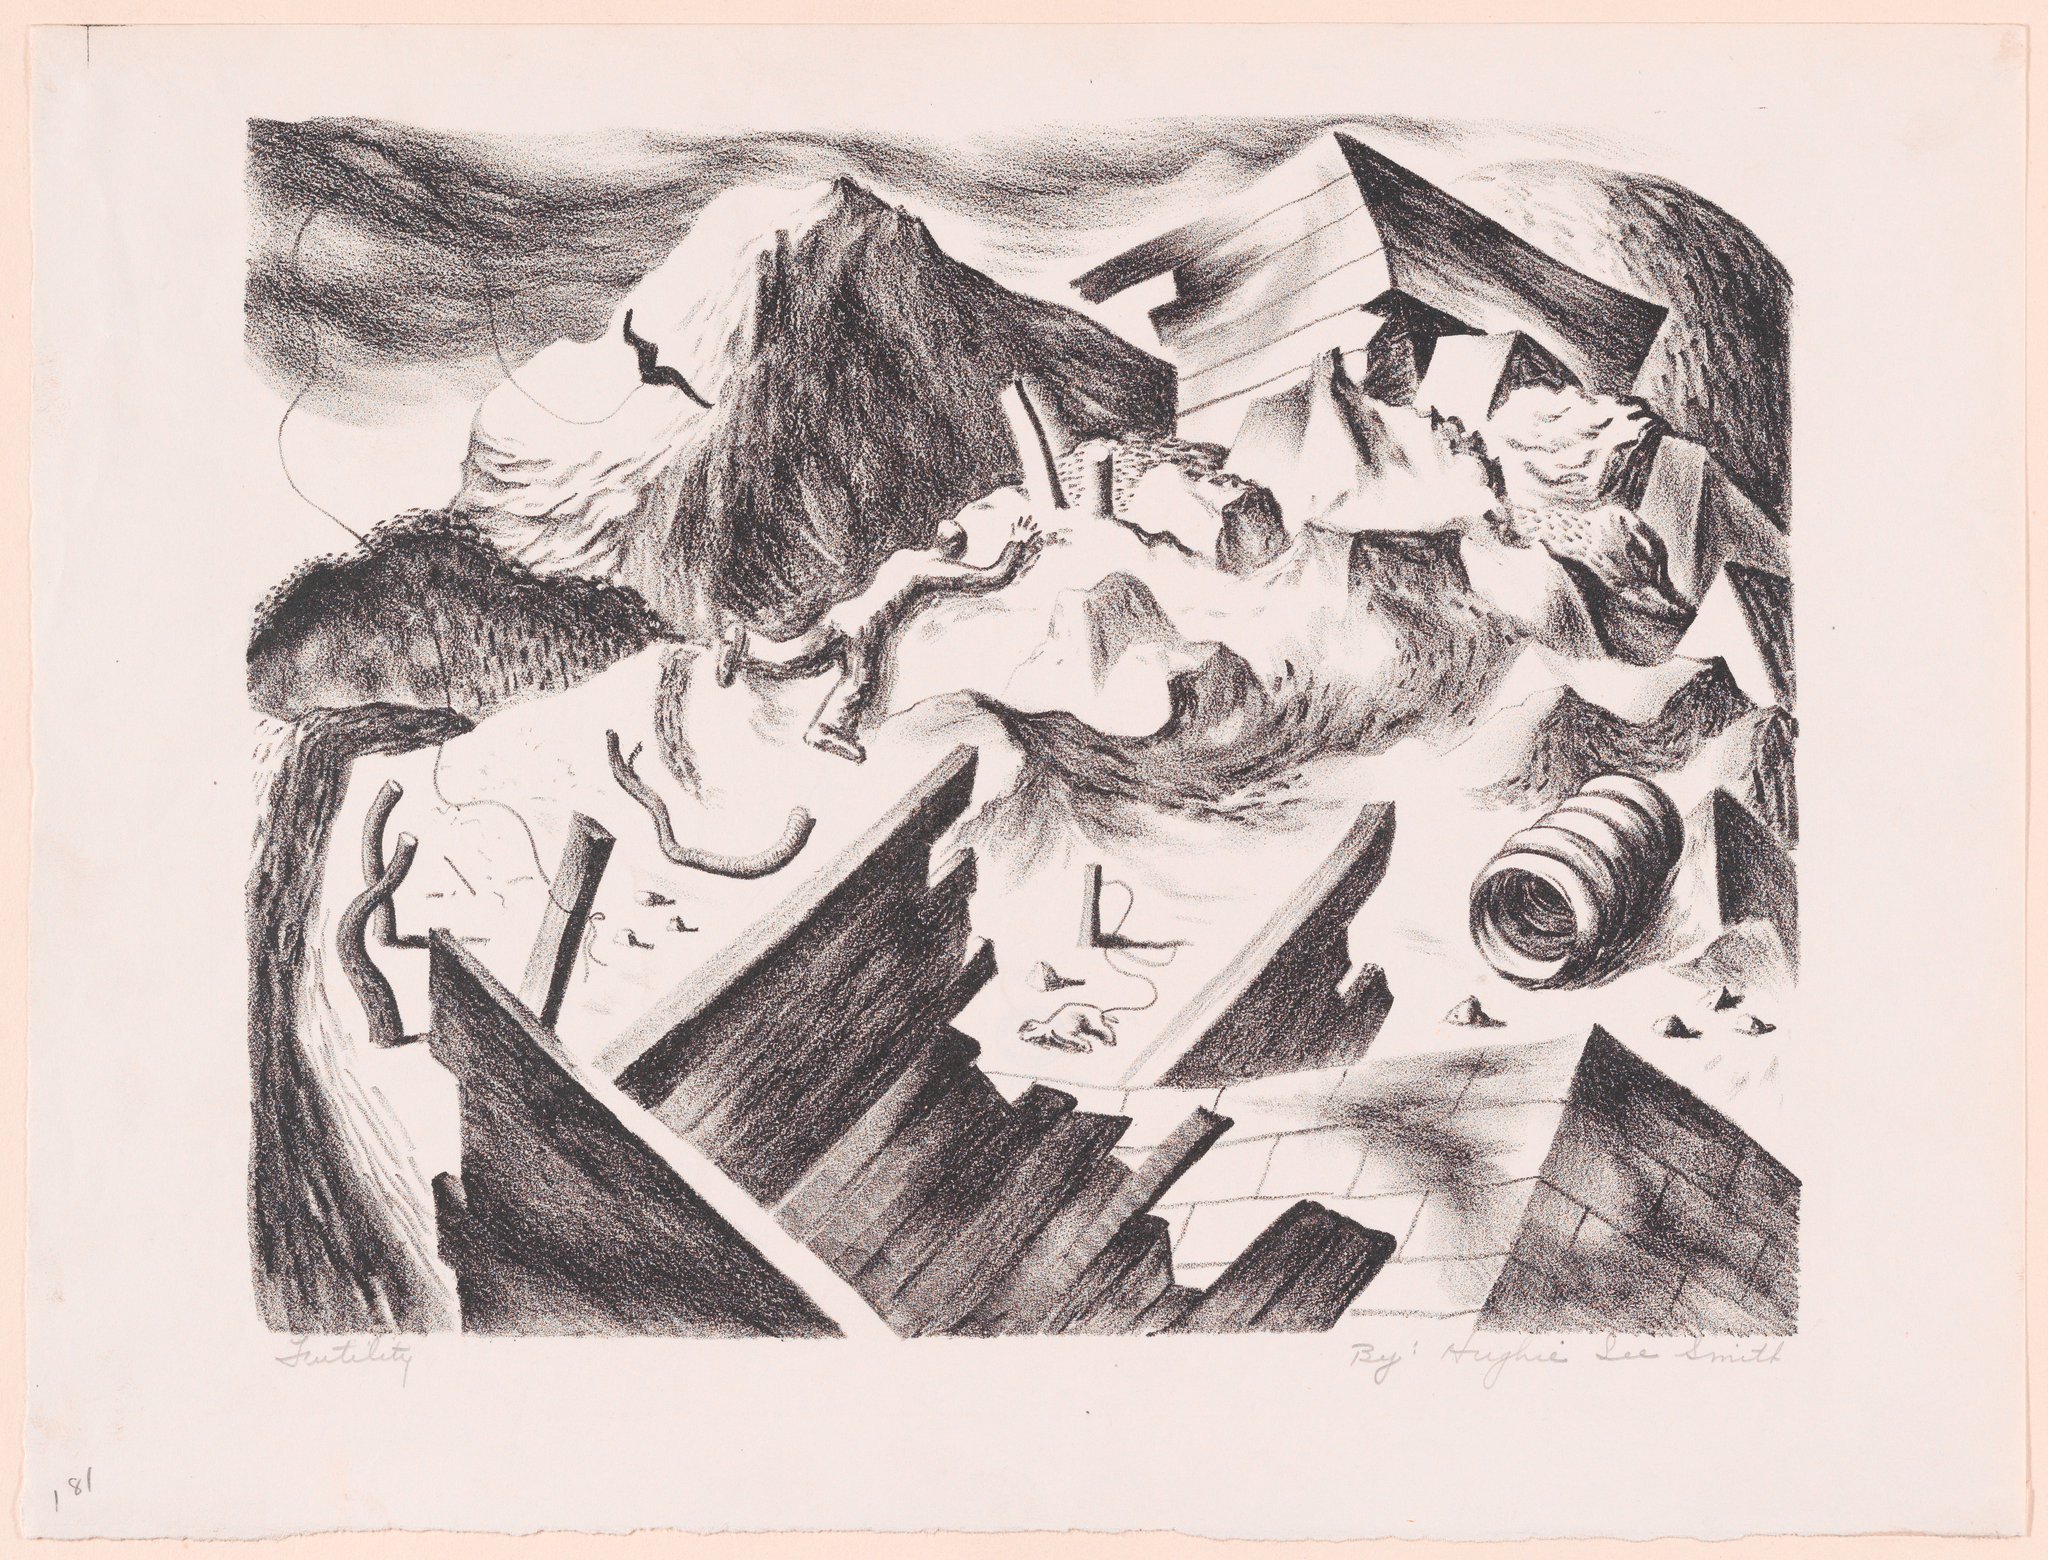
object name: print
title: Futility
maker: hughie lee-smith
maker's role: artist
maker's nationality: american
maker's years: 1915-1999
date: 1935-1943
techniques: lithograph